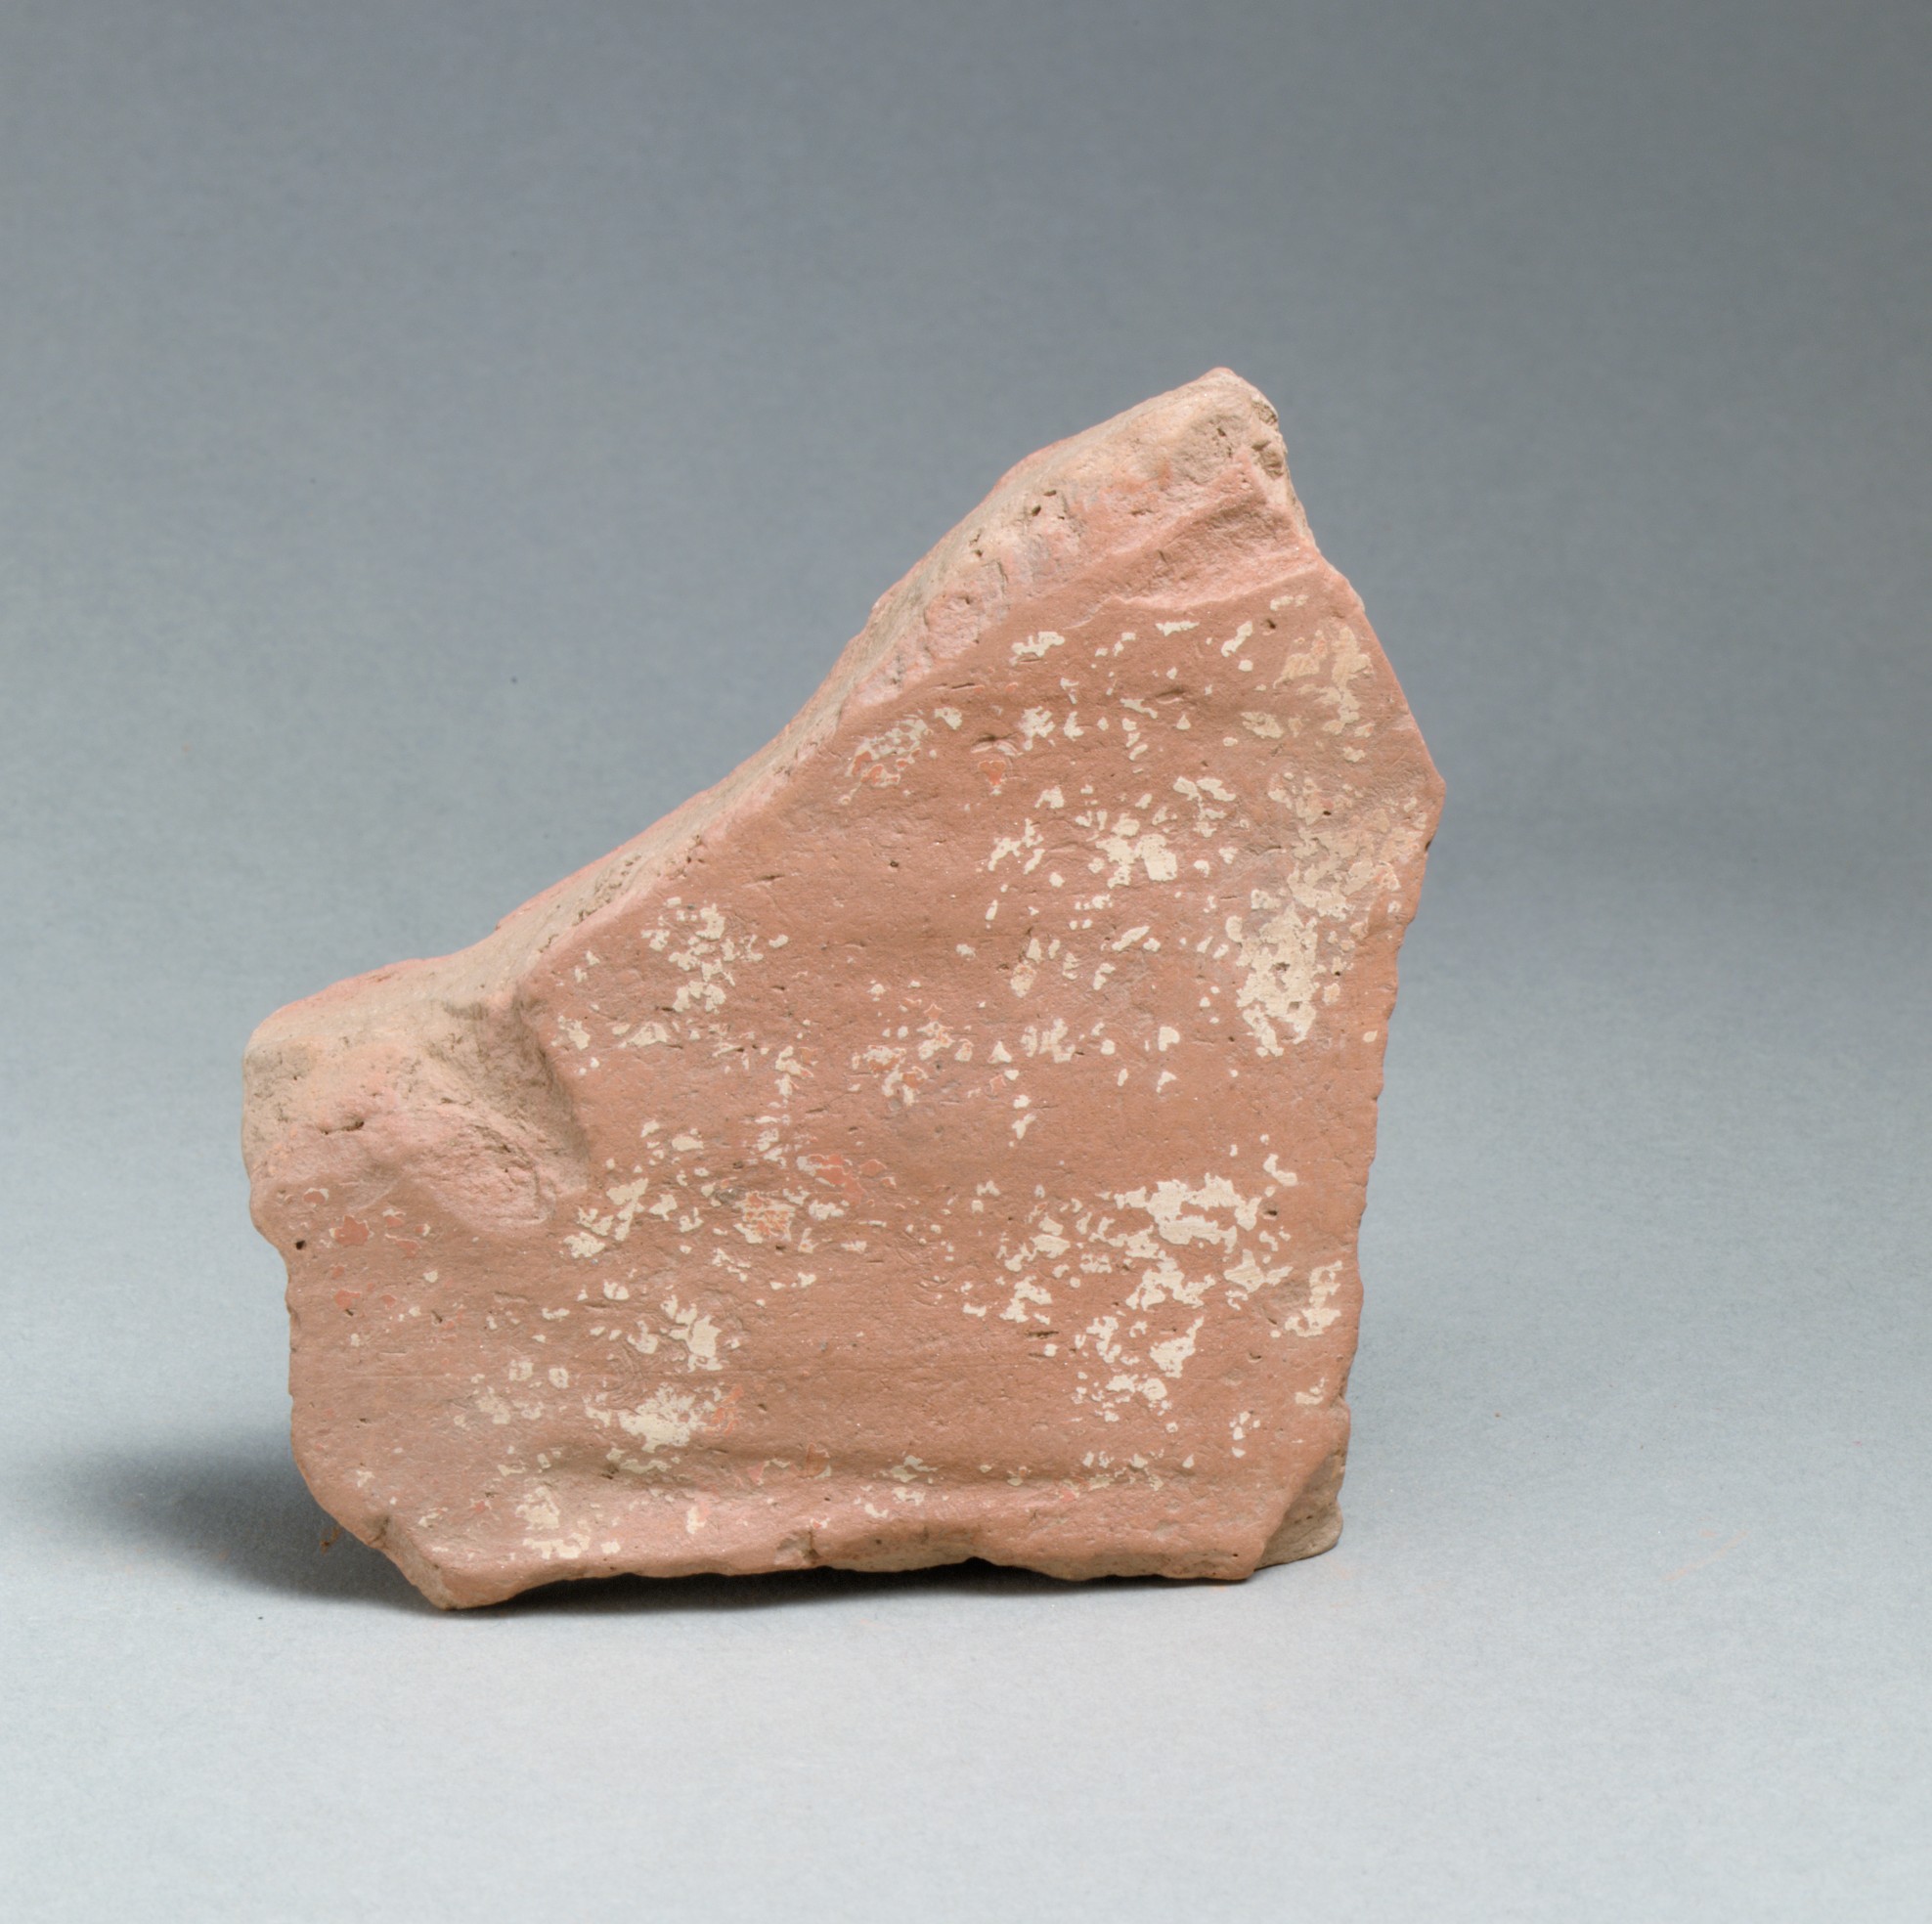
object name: vase fragment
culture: greek or lydian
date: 900-30 BCE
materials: terracotta